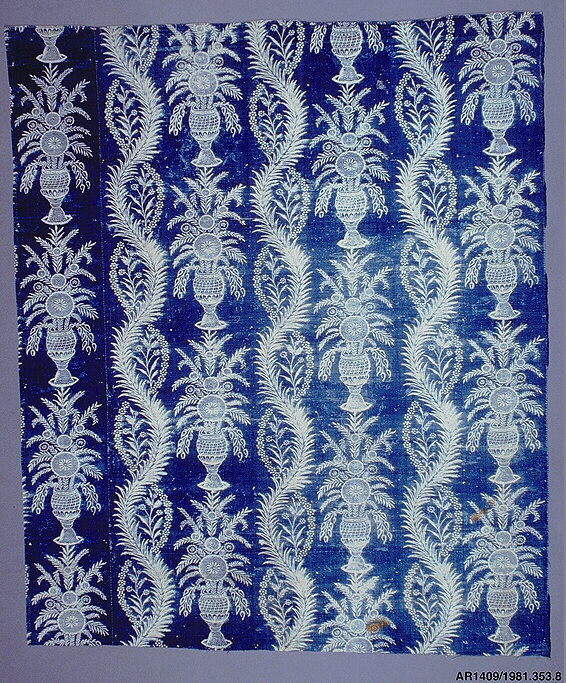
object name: piece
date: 1701-1800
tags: flowers